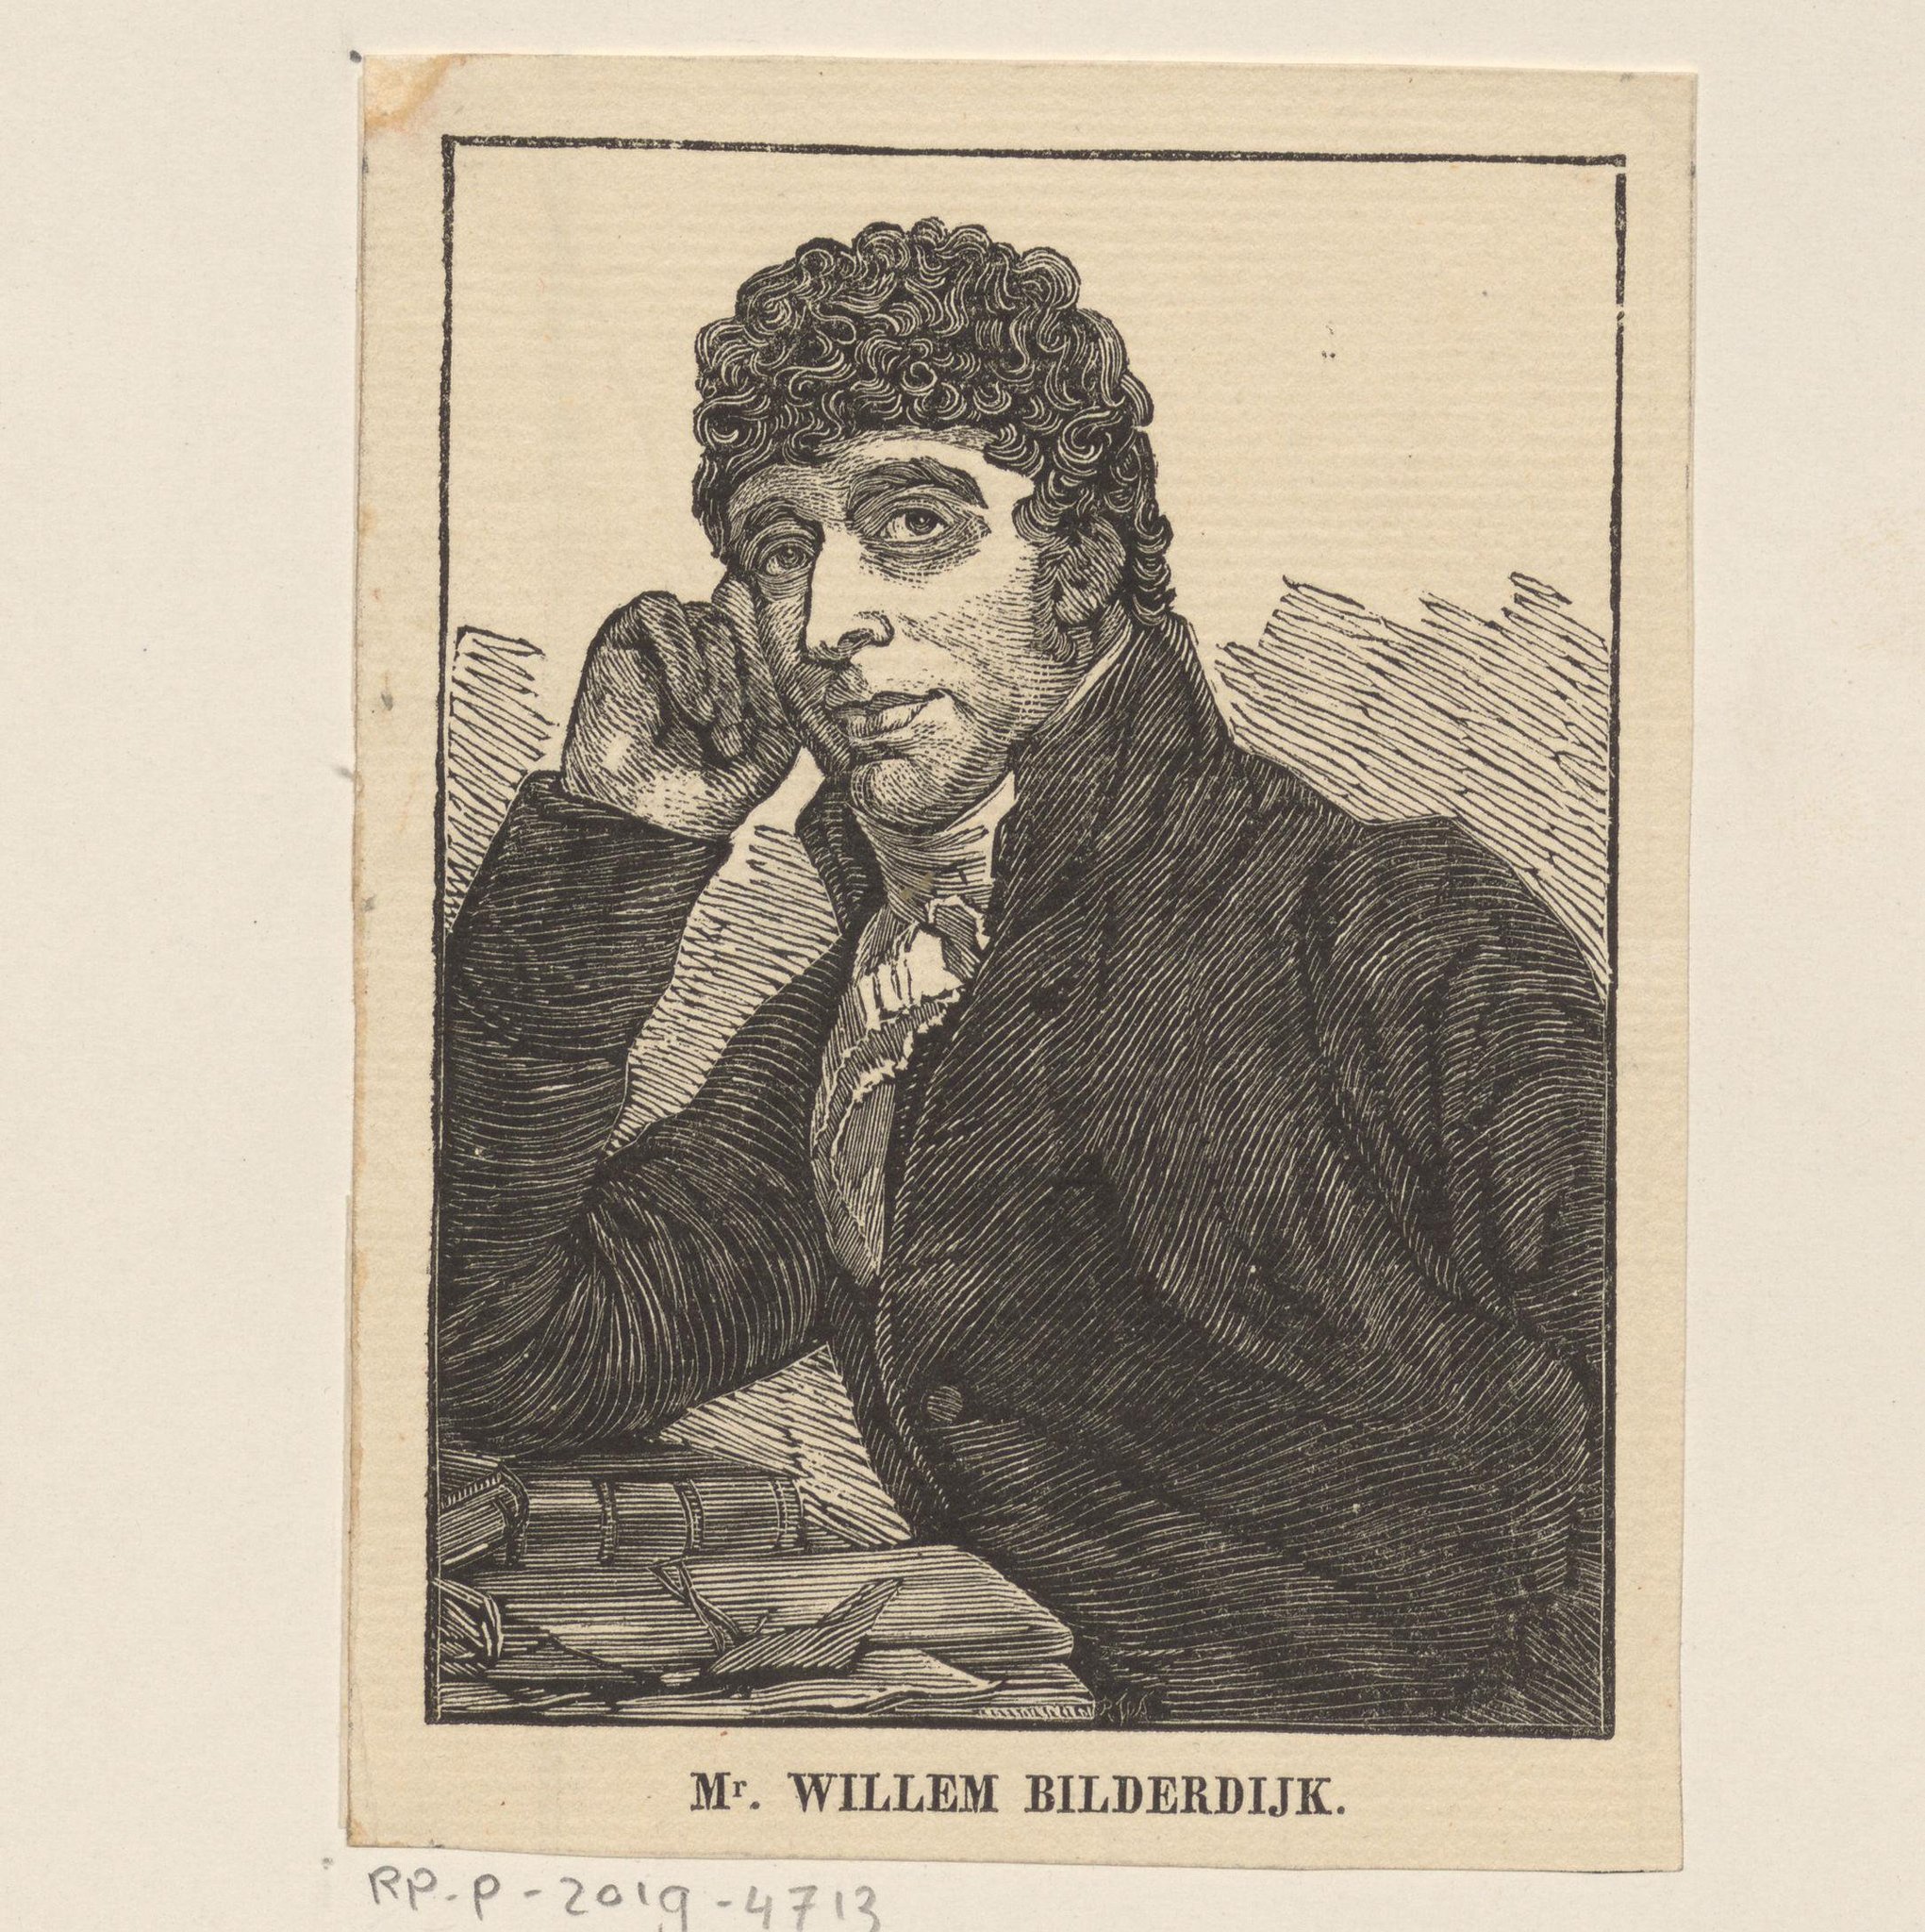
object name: print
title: Portret van Willem Bilderdijk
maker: Anonymous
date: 1810-1849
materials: paper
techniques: letterpress printing, engraving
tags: amsterdam, haarlem, print maker, draughtsman, willem bilderdijk, historical persons, portrait of a writer, book